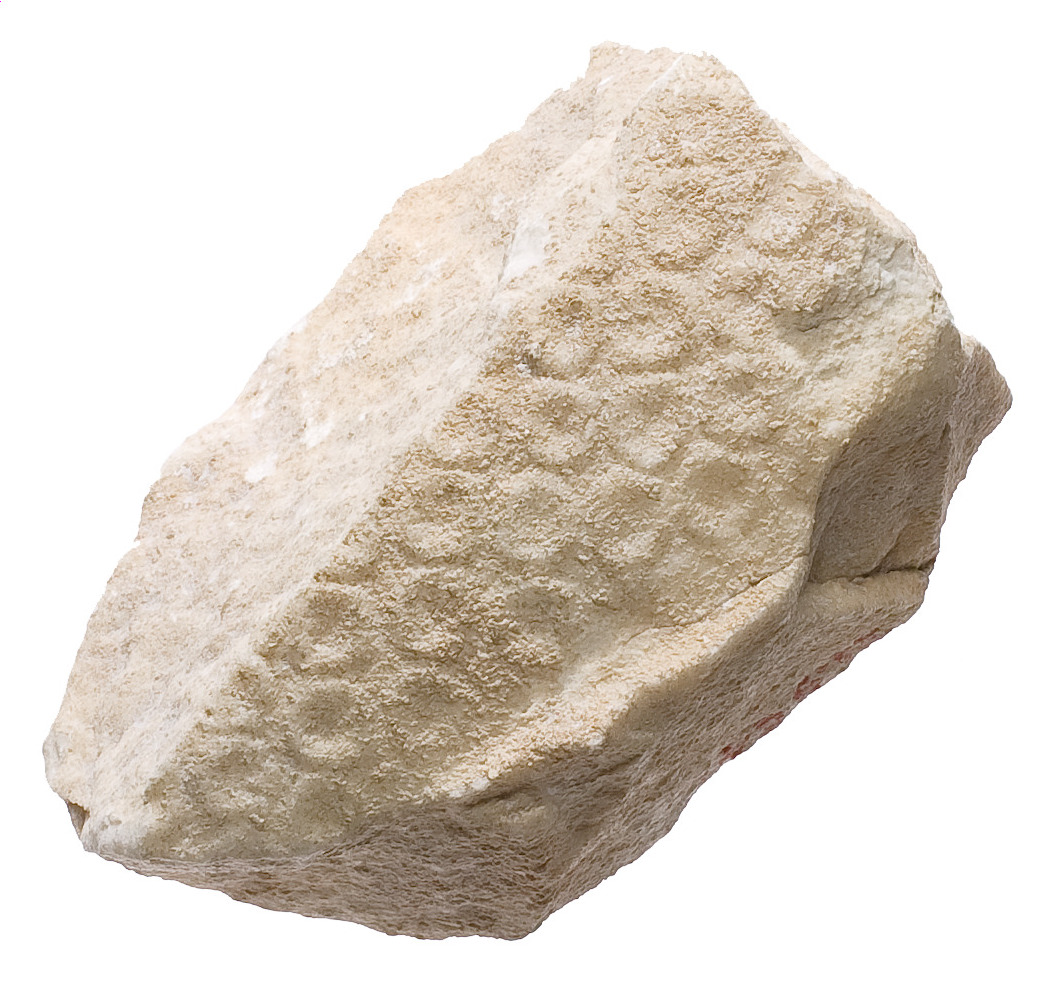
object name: crown fragment, disk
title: Crown with disks fragment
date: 1353-1336 BCE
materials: limestone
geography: egypt